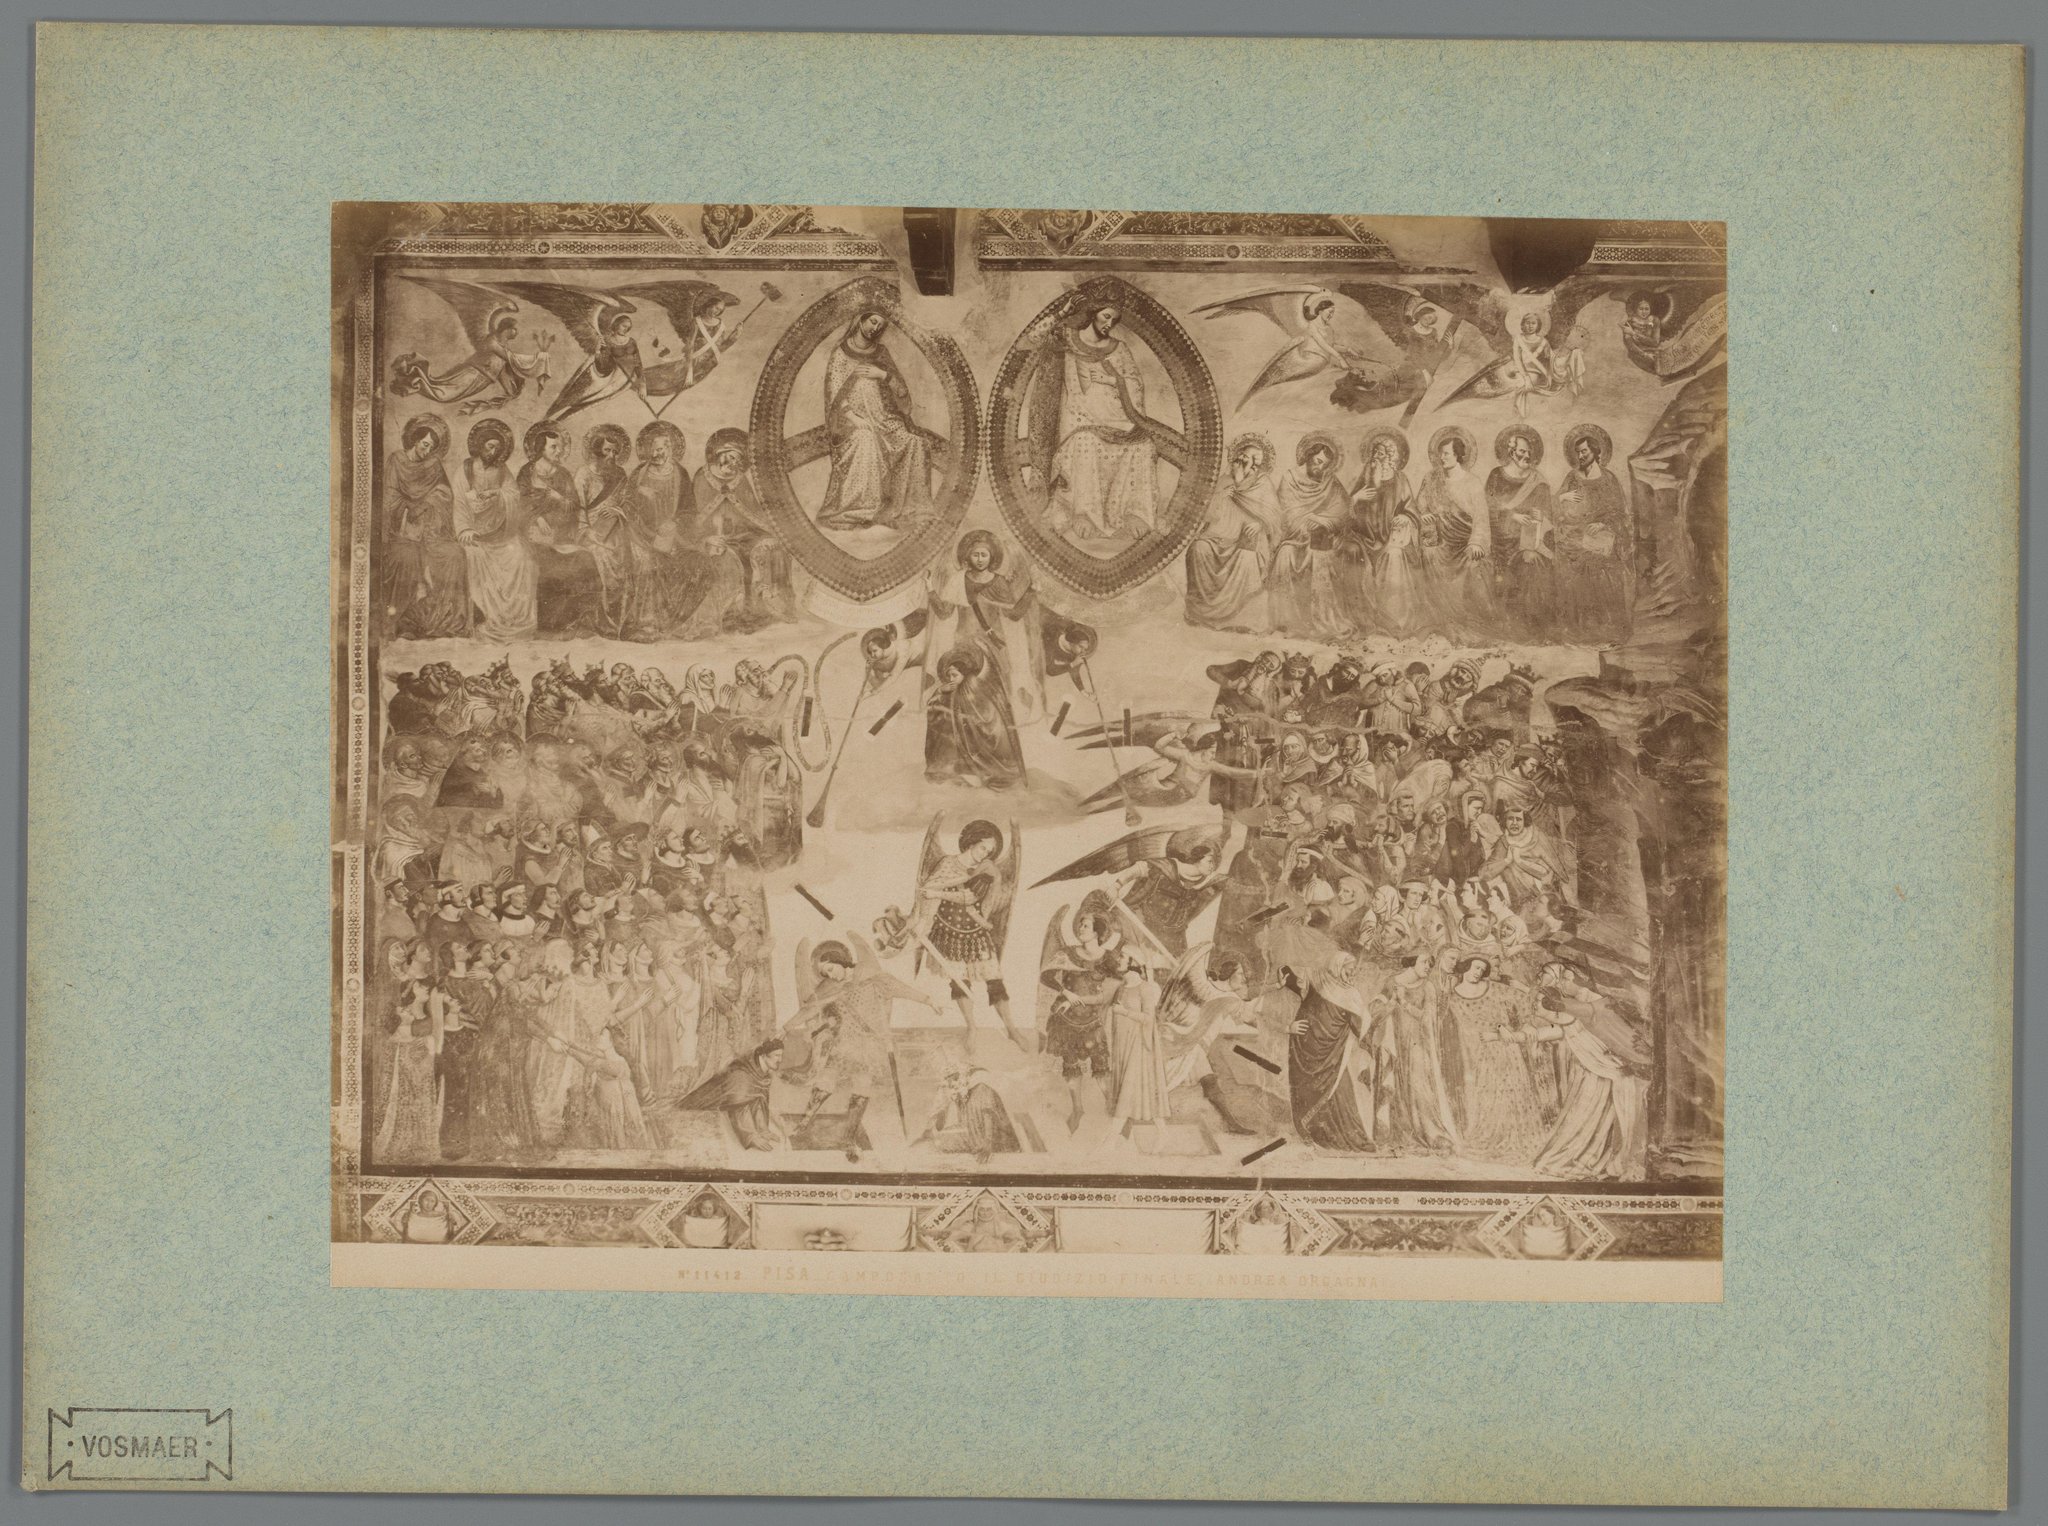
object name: reproduction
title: Pisa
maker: andrea di cione named orcagna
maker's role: painter, sculptor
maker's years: 1320-1368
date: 1852-1900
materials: cardboard, paper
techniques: albumen print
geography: pisa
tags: comprehensive representation of last judgement: christ (with sword and lily), often surrounded by elders and sometimes accompanied by mary and john the baptist, appears in the sky with trumpeting angels (and sometimes angels holding the instruments of the passion); after the resurrection of the dead the blessed are led to heaven by angels, and the damned are dragged into hell by devils, wall-covering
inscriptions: number: ‘No. 11412’, collector's mark: ‘VOSMAER’